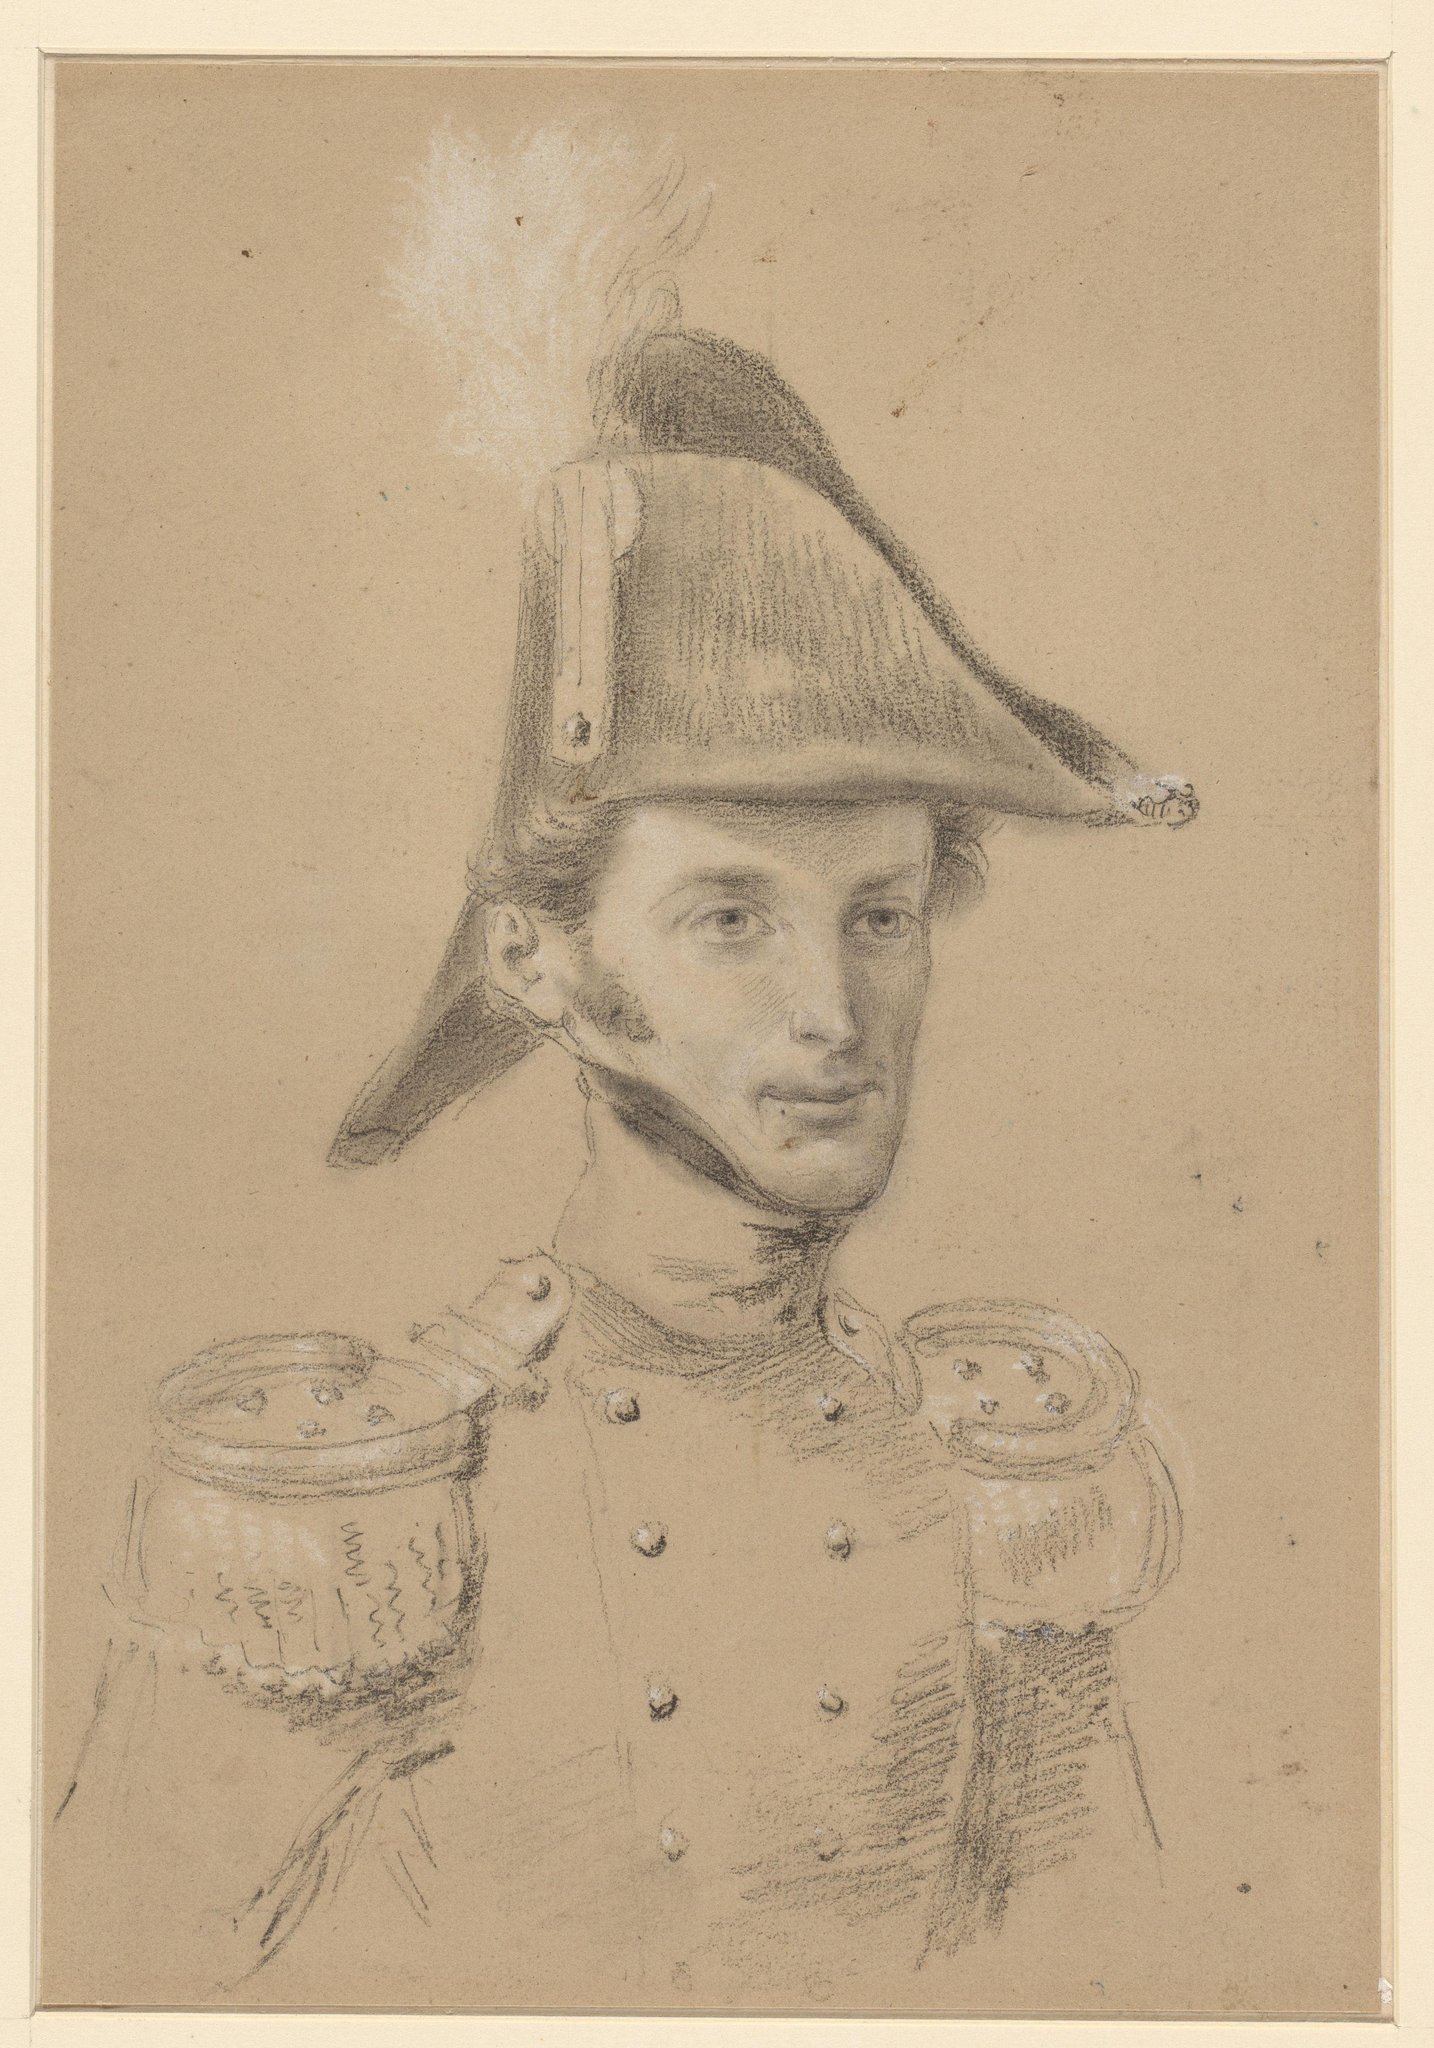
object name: drawing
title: Portret van Prins Frederik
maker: jacob joseph eeckhout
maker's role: draughtsman, print maker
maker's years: 1793-1861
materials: chalk, paper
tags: berlin, frederik (prins der nederlanden), historical persons